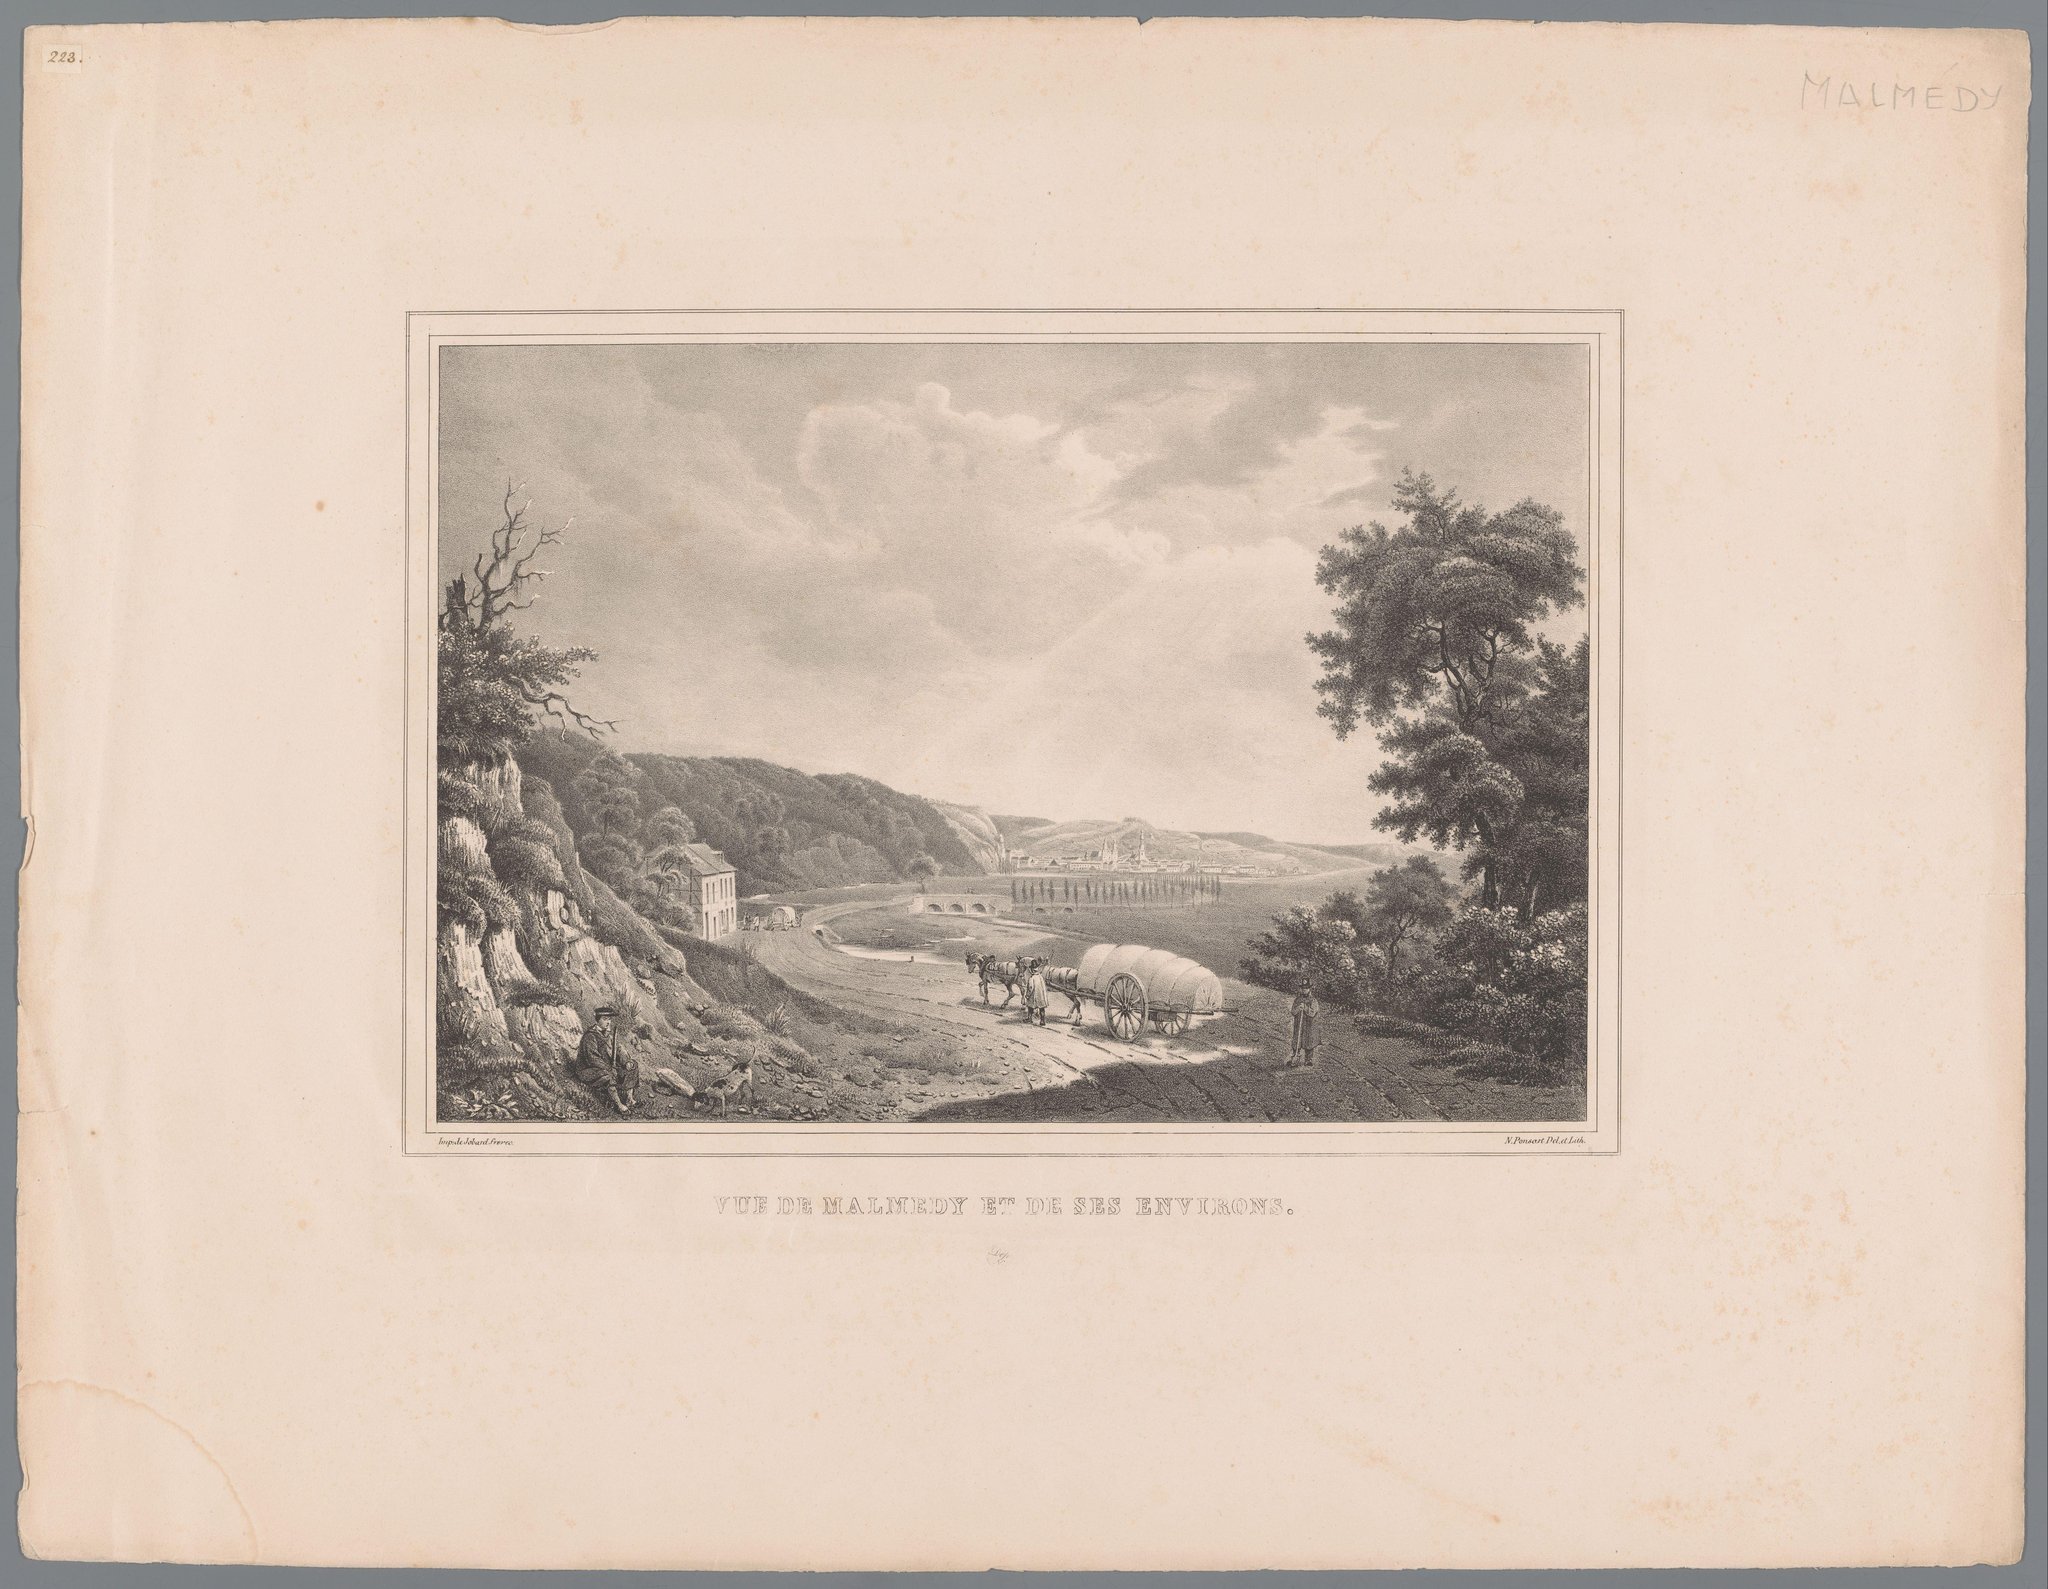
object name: print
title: Gezicht op Malmedy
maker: jean nicolas ponsart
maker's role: print maker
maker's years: 1788-1870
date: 1817-1861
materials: paper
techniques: lithograph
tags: city-view in general; 'veduta', (farm) wagon, freight wagon, cart